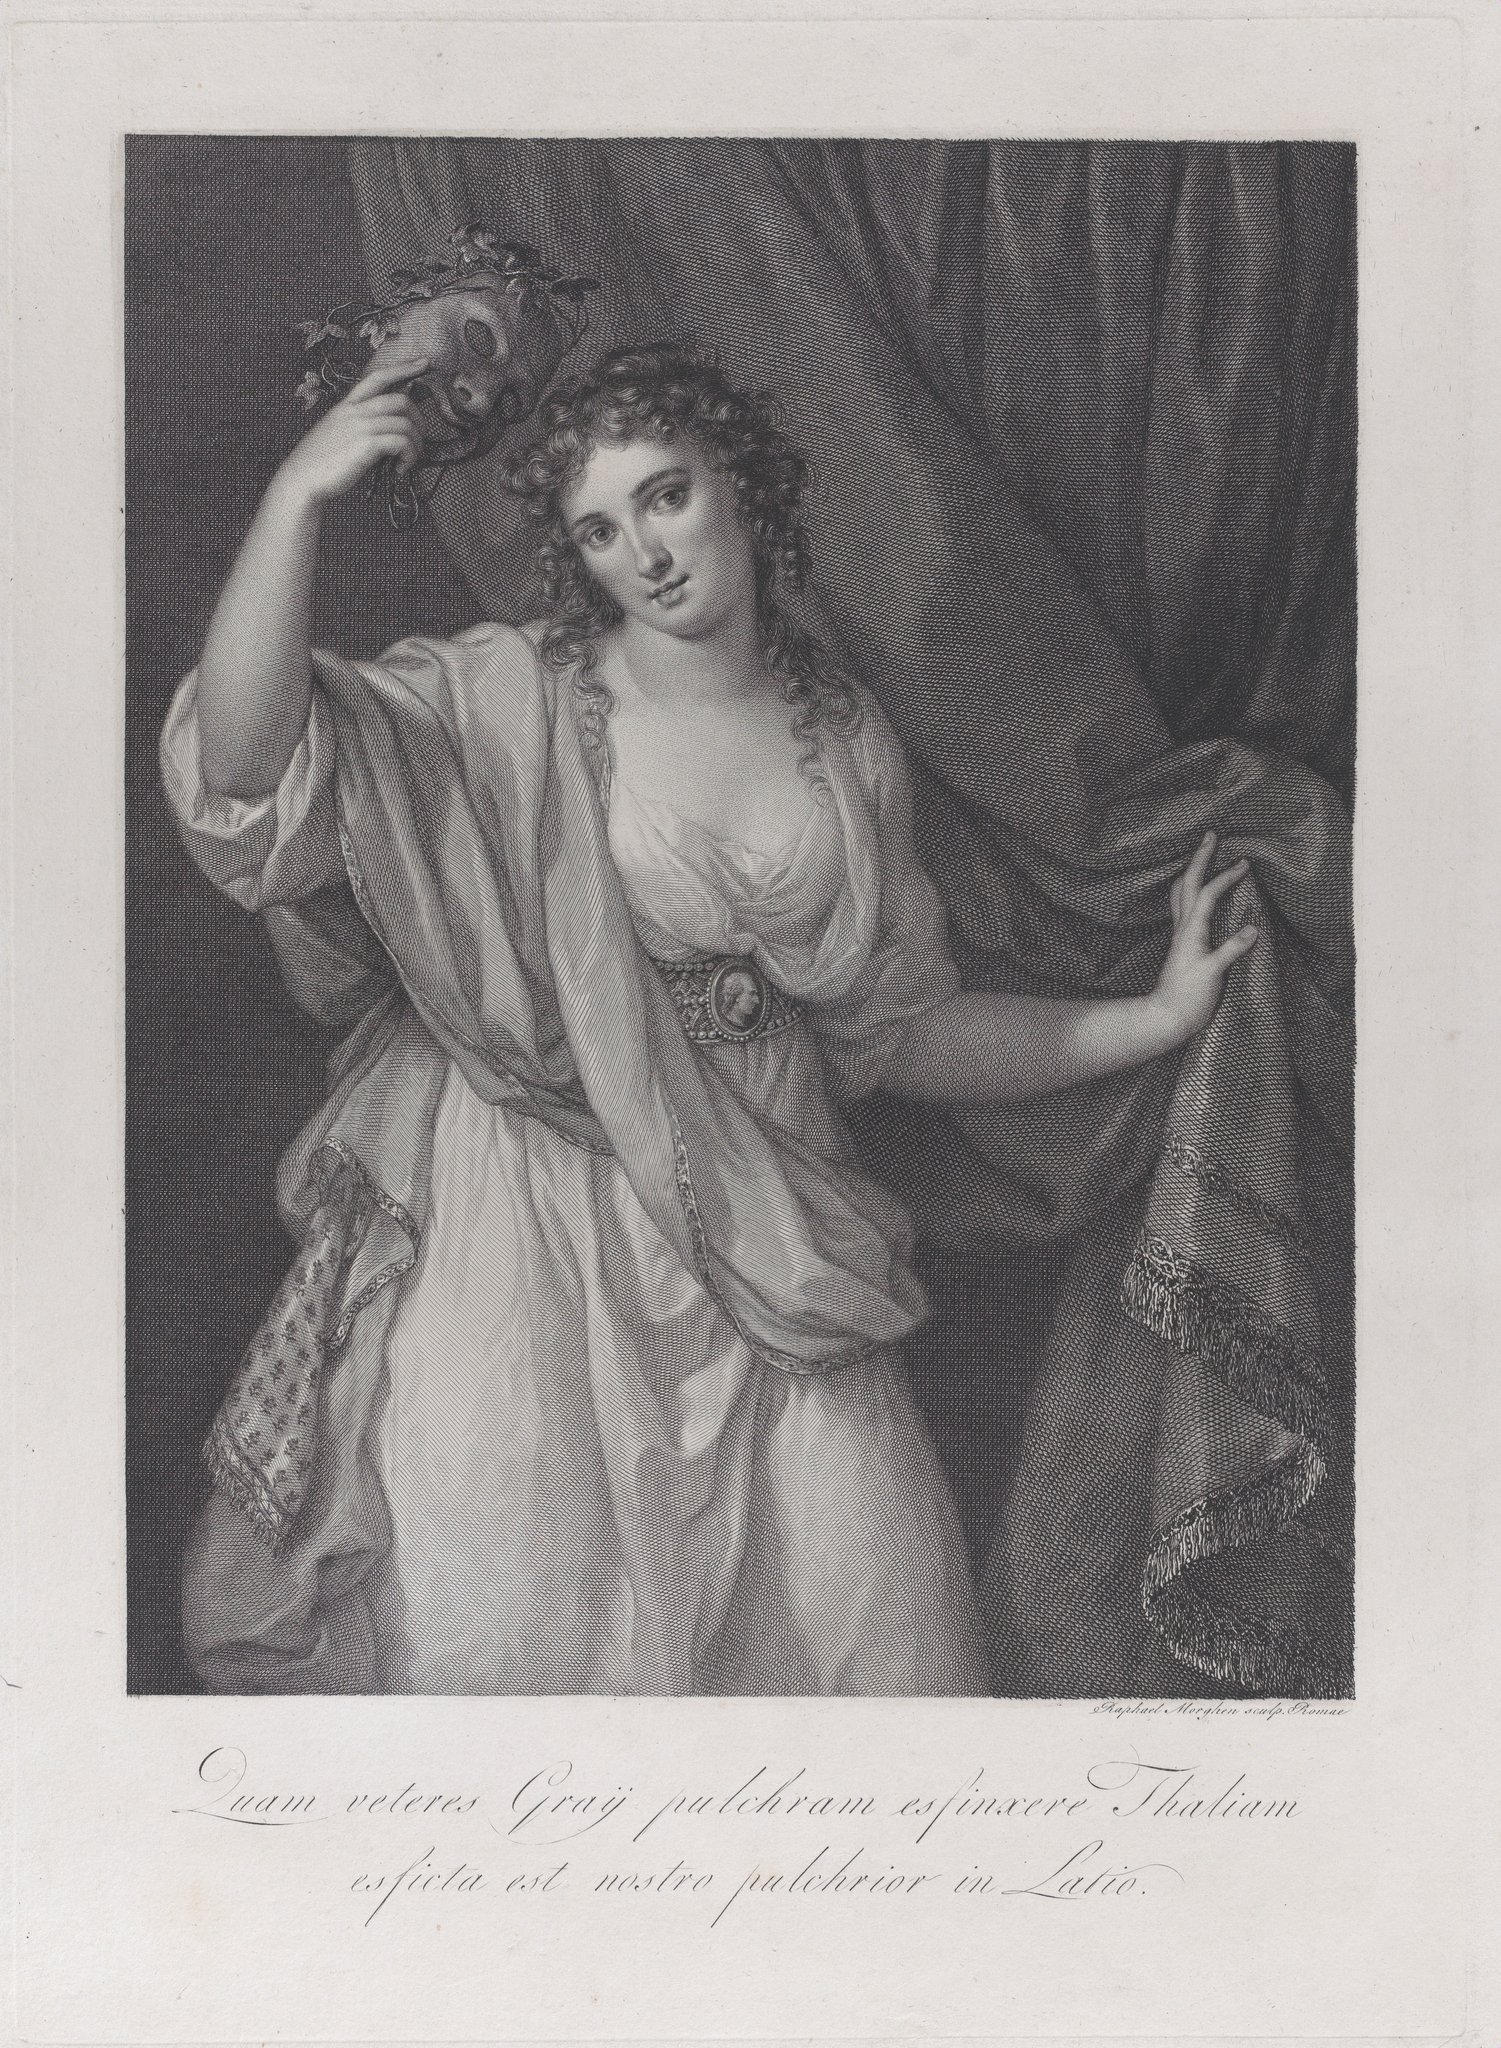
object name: print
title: Lady Hamilton as the Comic Muse, Thalia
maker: raphael morghen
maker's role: artist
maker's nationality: italian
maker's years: 1758-1833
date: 1791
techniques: engraving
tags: portraits,women,actresses